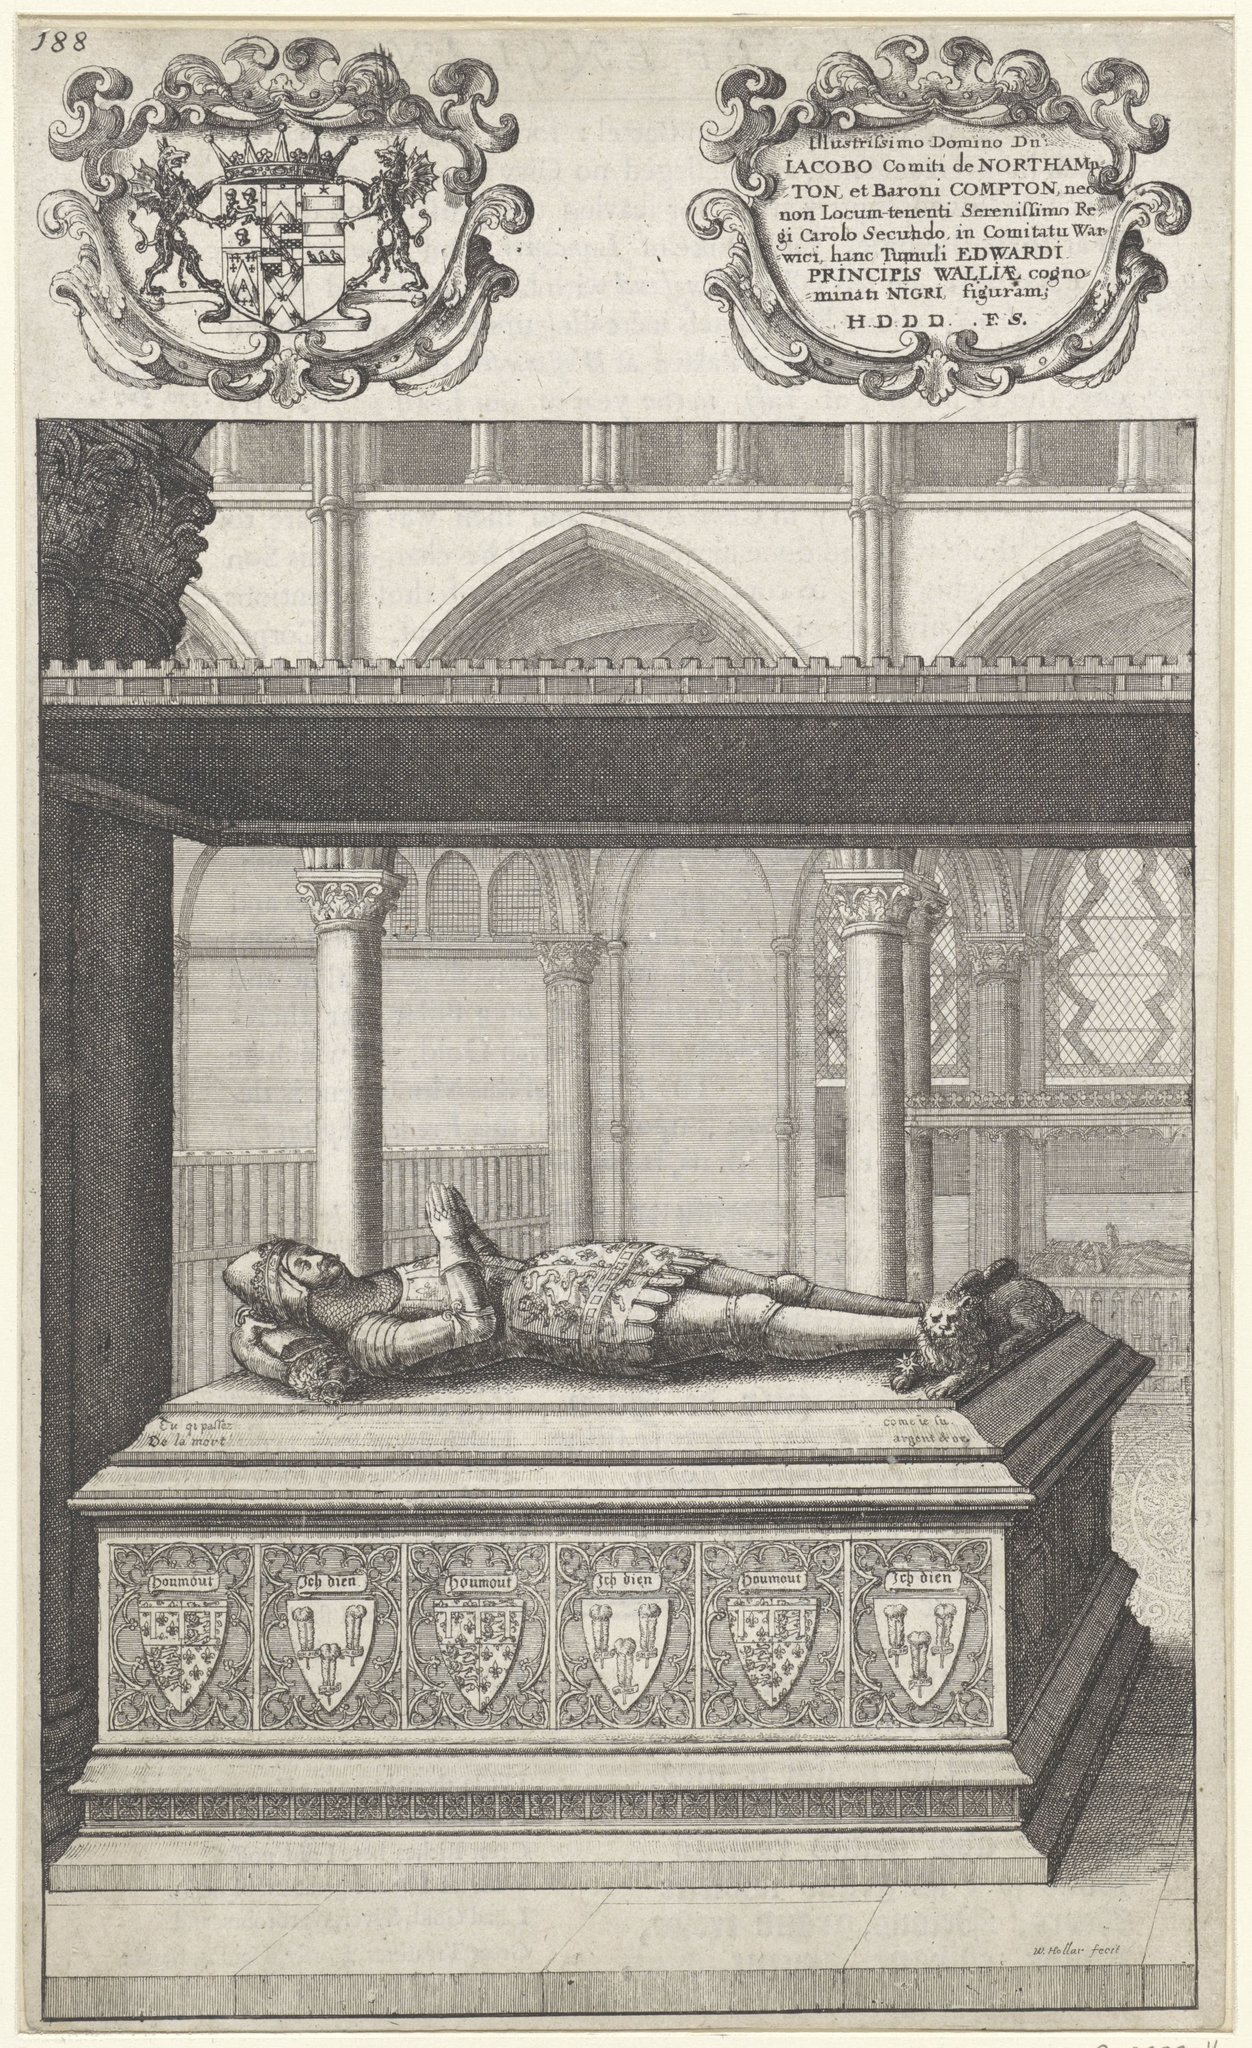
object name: print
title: Grafmonument van Eduard van Woodstock, prins van Wales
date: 1677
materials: paper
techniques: etching, letterpress printing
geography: london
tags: grave-building, monumental tomb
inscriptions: collector's mark: Lugt 2228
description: Illustratie uit: Sandford, Francis. A Genealogical History of the Kings of England, 1677, 1683, 1707.